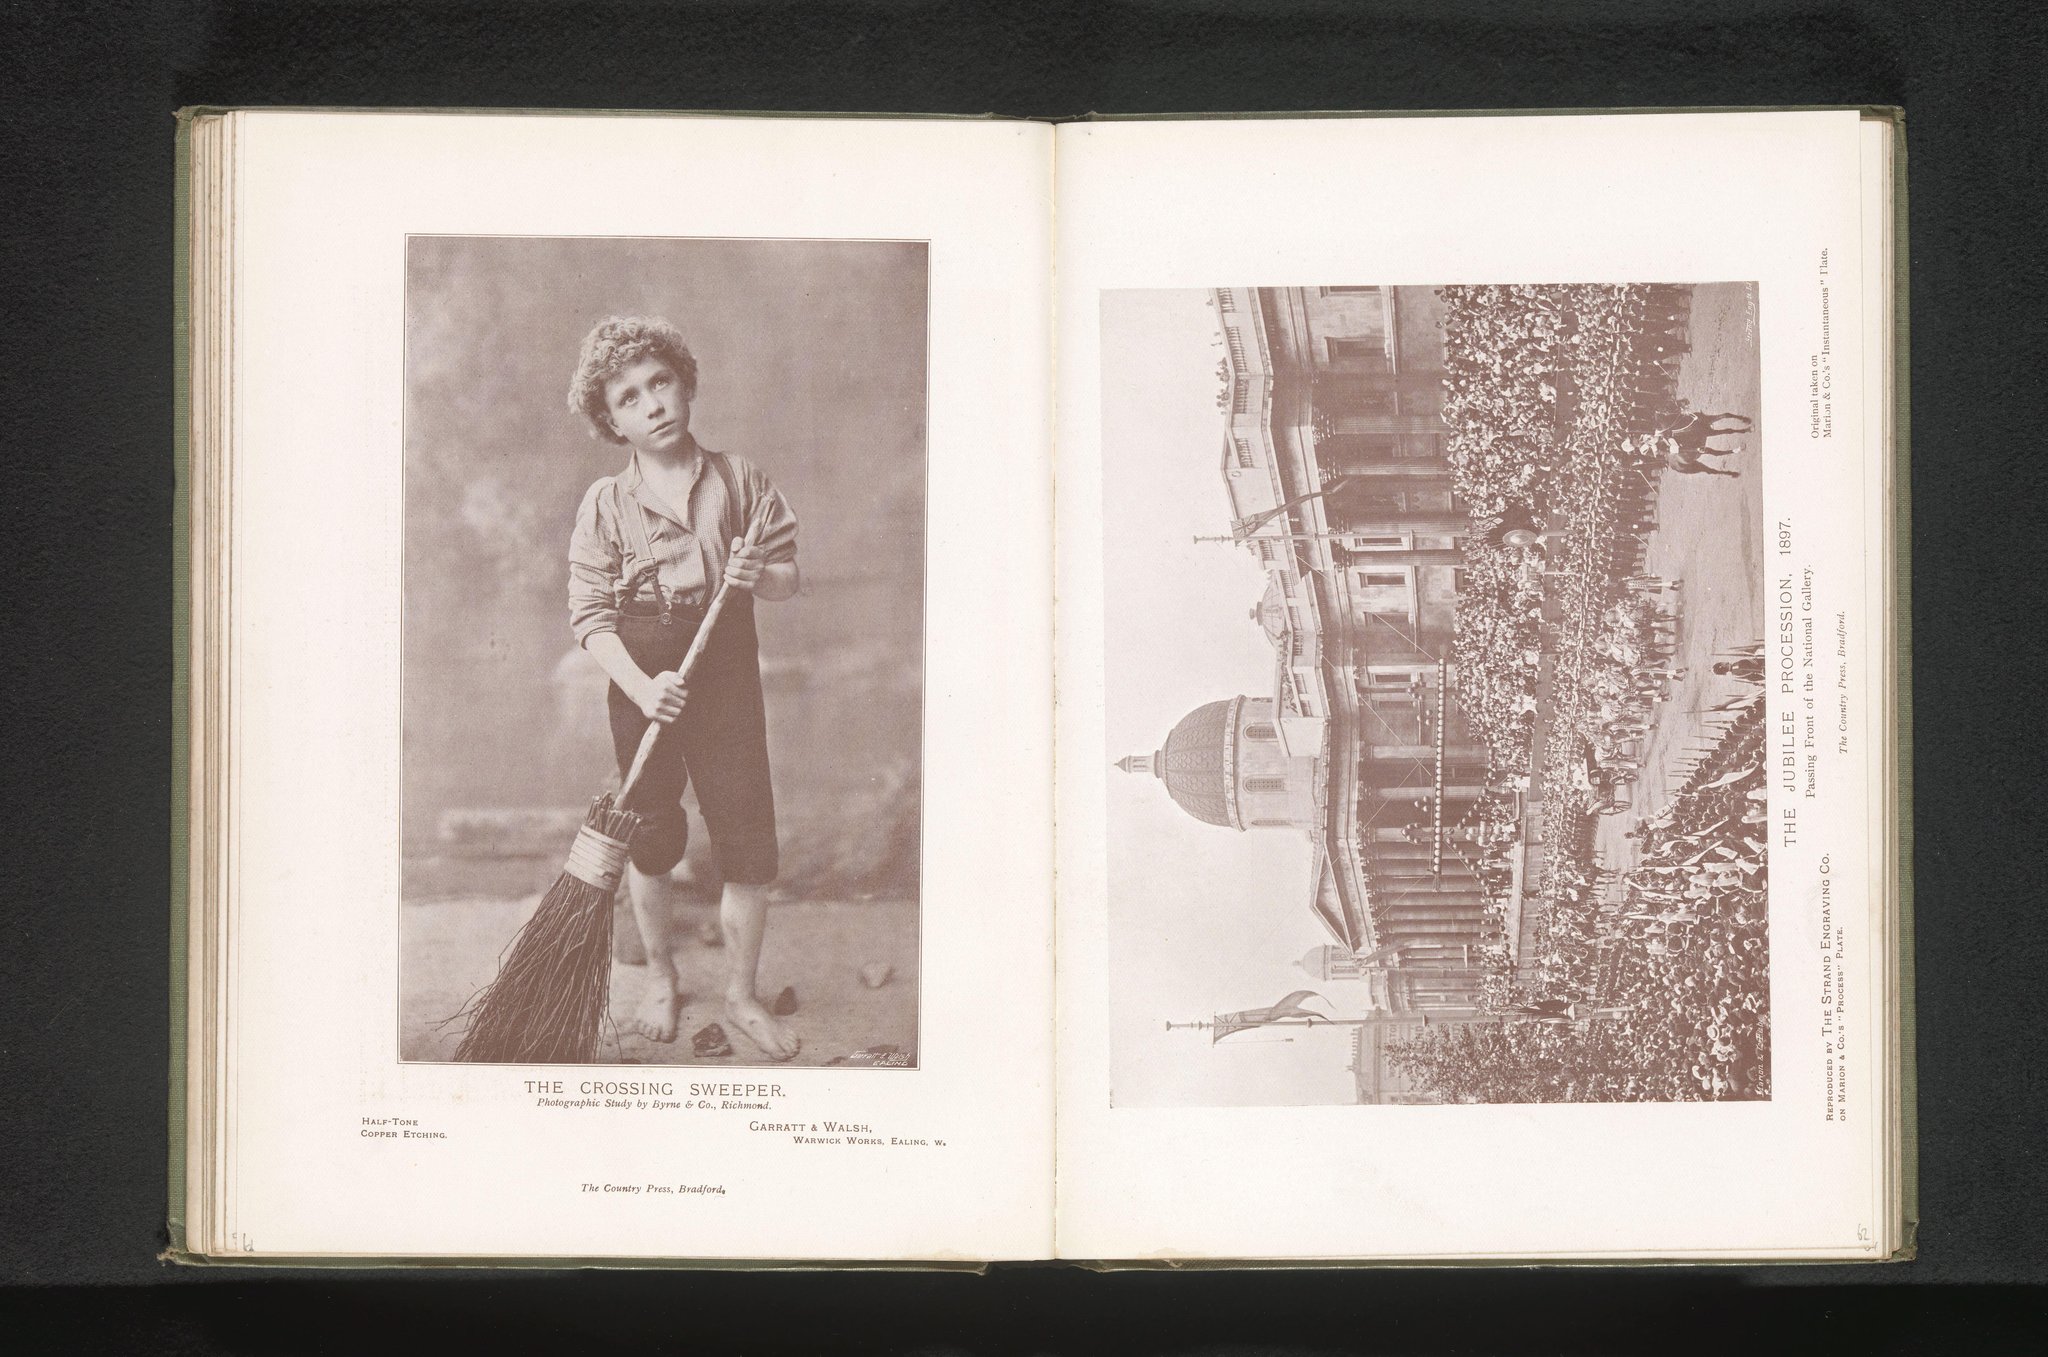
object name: page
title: Jongen met bezem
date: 1893-1898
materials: paper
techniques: autotype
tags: boy (child between toddler and youth), historical persons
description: Prent op vierde ongenummerde pagina na pagina 80.